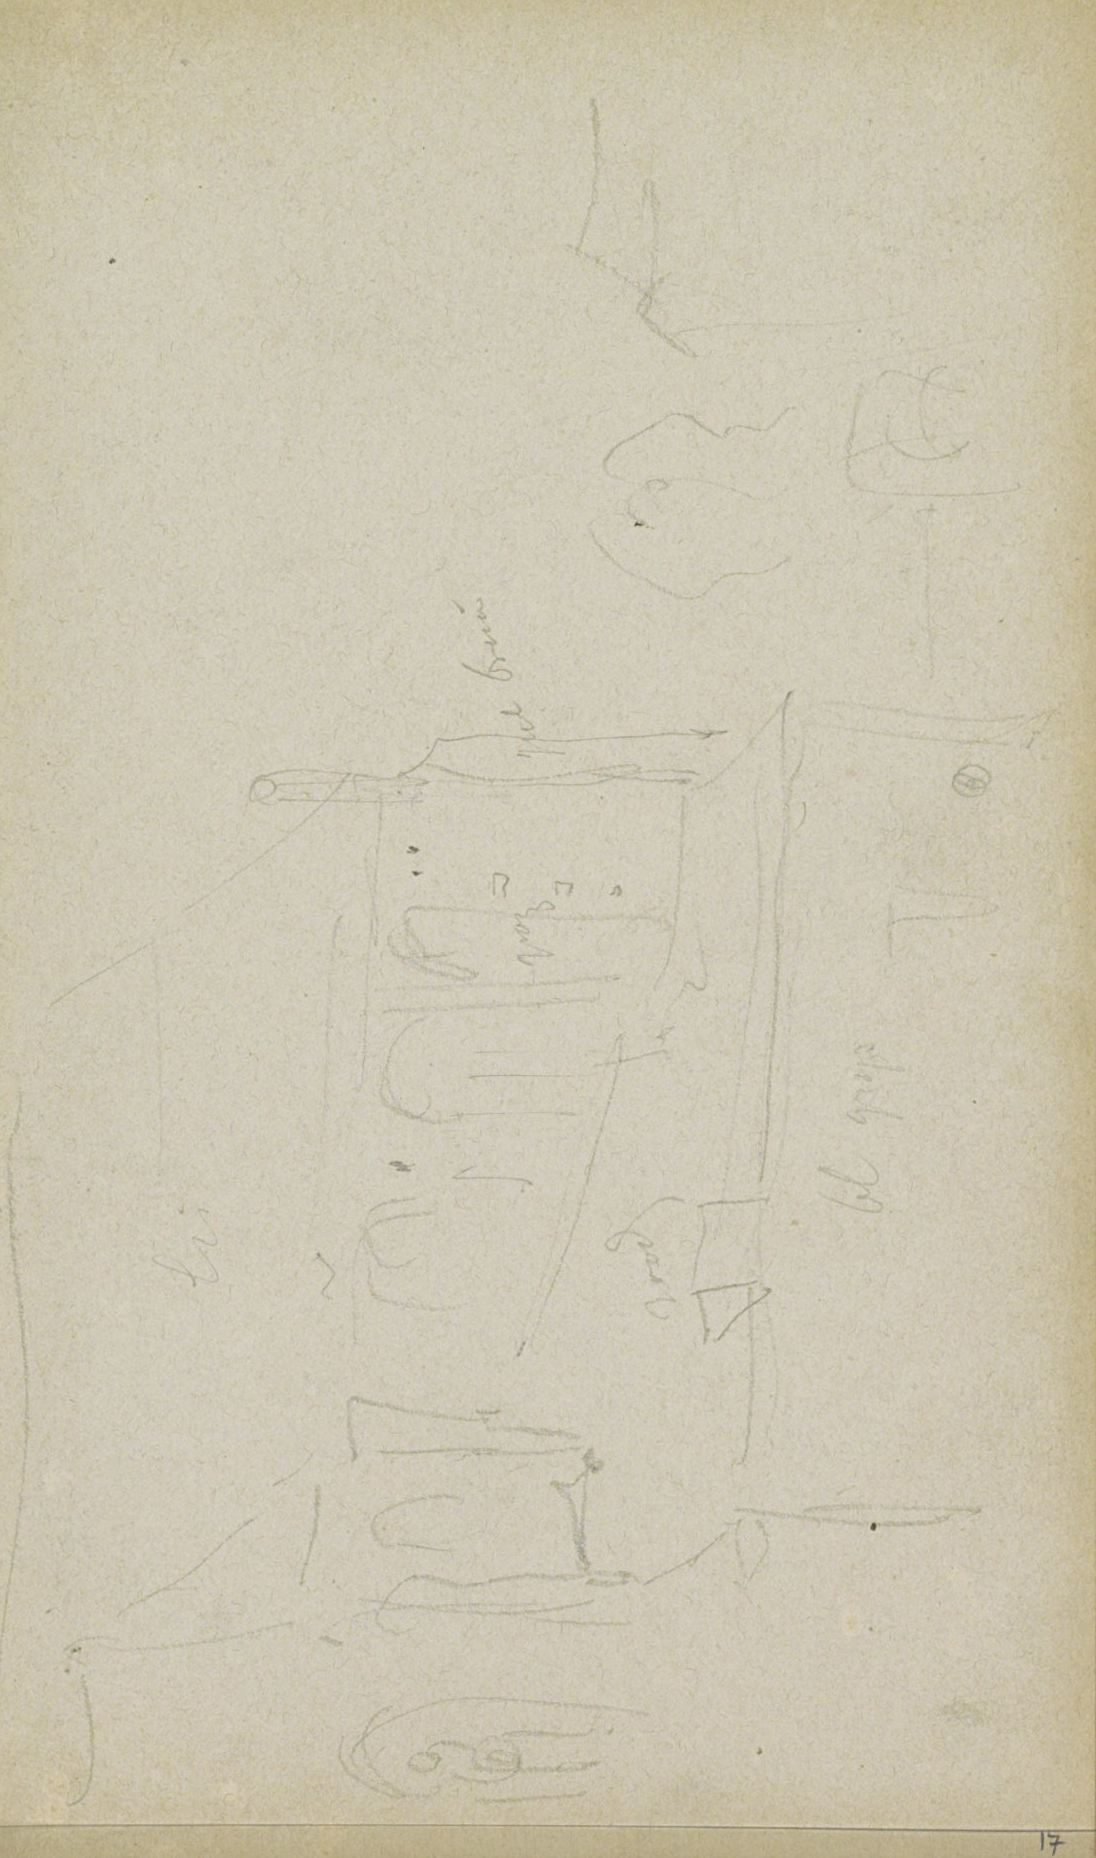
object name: sketchbook leaf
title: Stadsgezicht met een kerk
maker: adrianus eversen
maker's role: draughtsman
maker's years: 1818-1897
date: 1828-1897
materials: paper, pencil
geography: netherlands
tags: city-view, and landscape with man-made constructions, church (exterior)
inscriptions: kleurnotitie, handgeschreven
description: Gezicht op een deel van een kerk. Rechts bebouwing en een boom. Blad 17 recto uit een schetsboek met 69 bladen vervaardigd in de omgeving van Delft, Rotterdam, Oudewater en Harlingen.